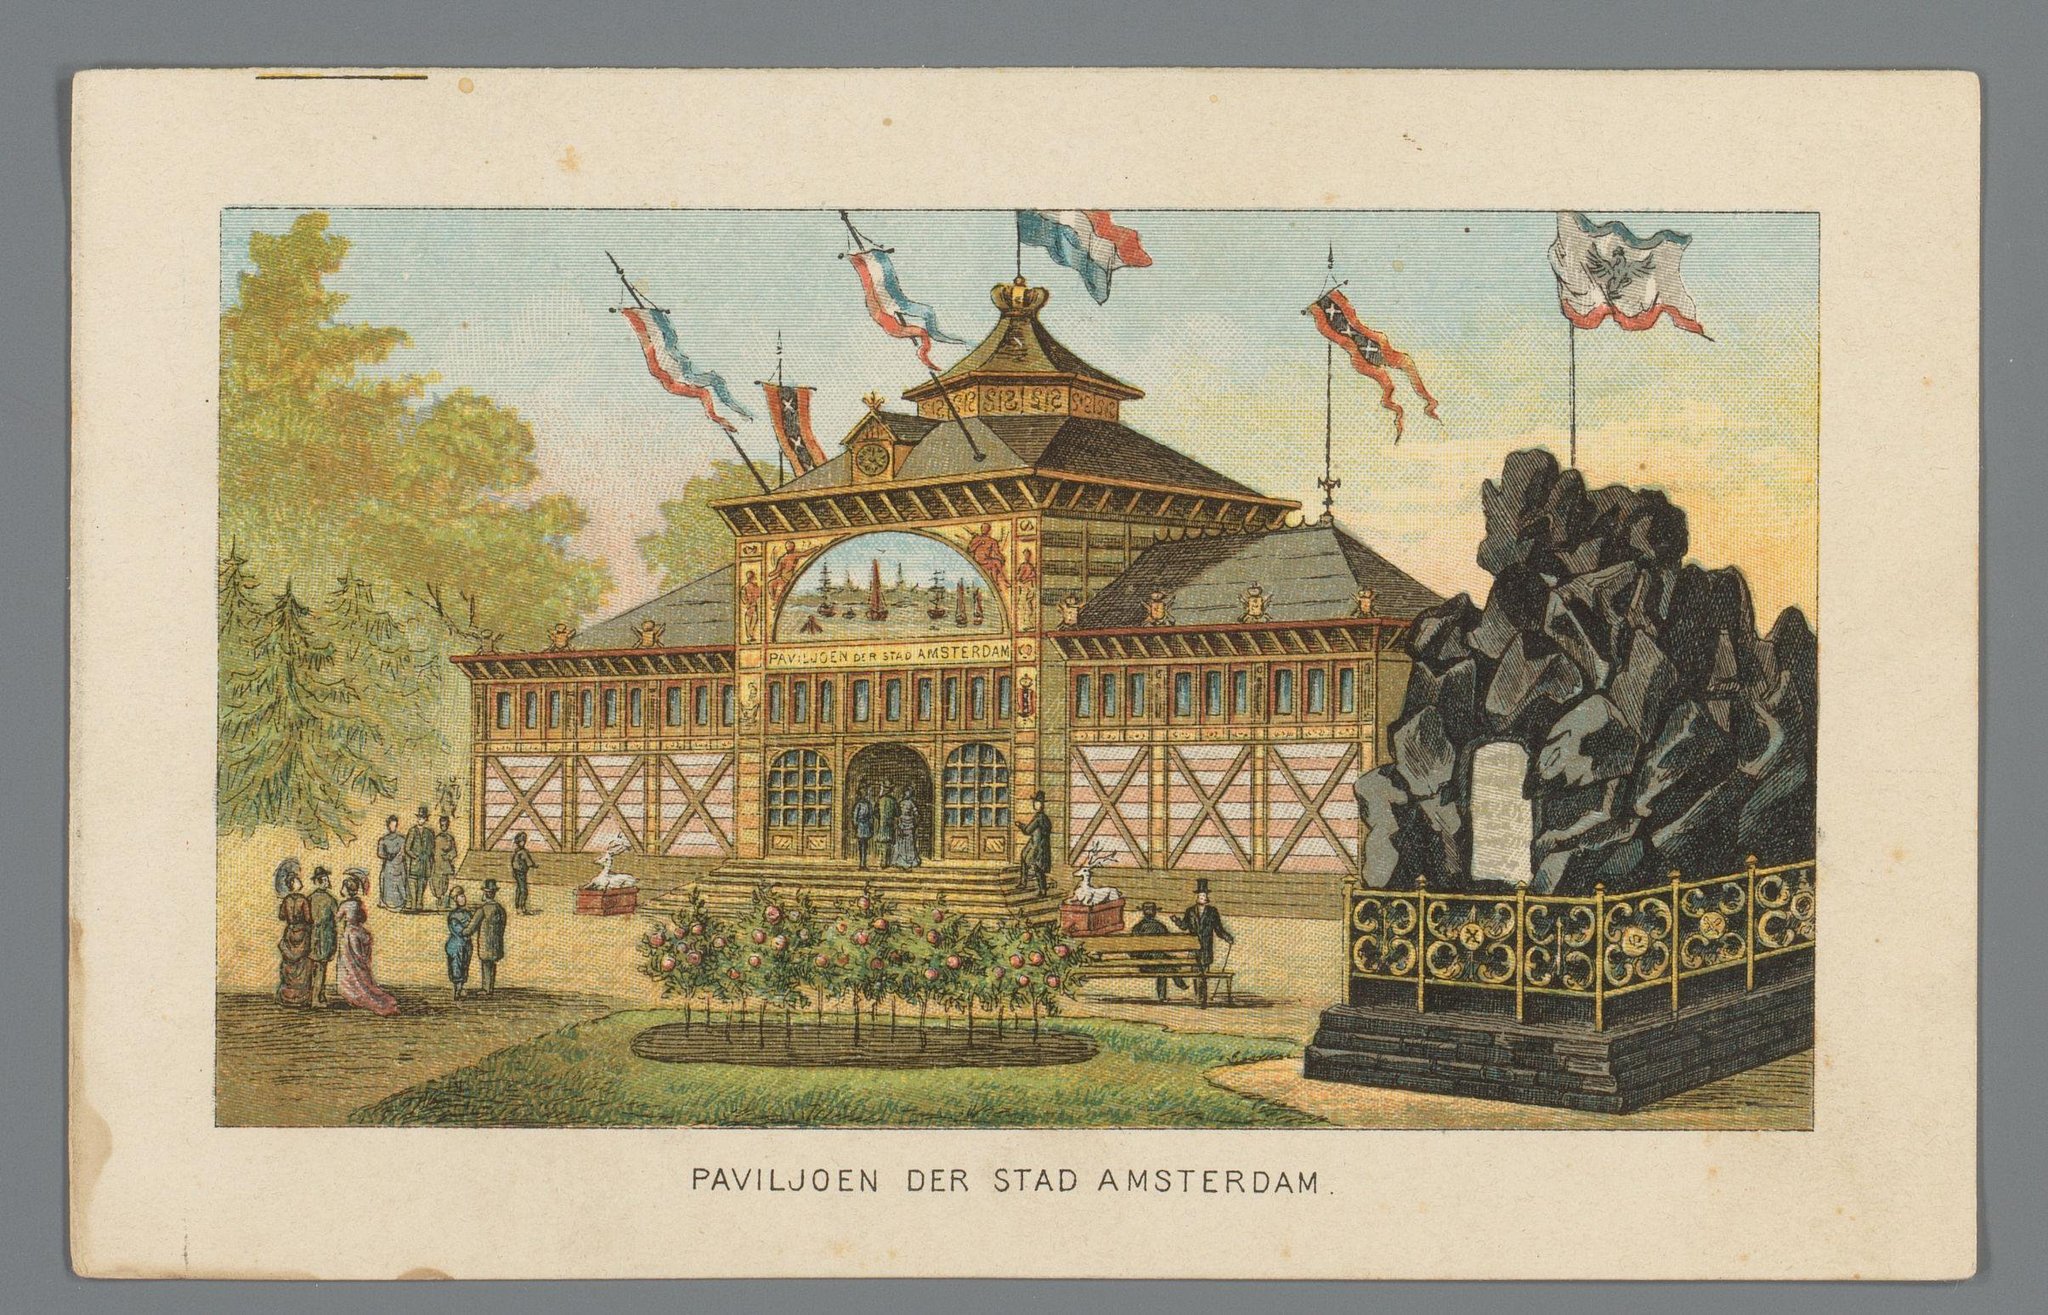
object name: print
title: Herinnering aan Amsterdam in 1883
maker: Anonymous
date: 1883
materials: paper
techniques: chromolithography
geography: amsterdam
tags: world fair, world exhibition, amsterdam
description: Deze prent komt voor in: Herinnering aan Amsterdam in 1883. Amsterdam: Het Nieuws van den Dag, 1883. Dit is een serie van zestien prenten over de wereldtentoonstelling in Amsterdam, 1883, met daarbij een plattegrond van het tentoonstellingsterrein en een omslag.